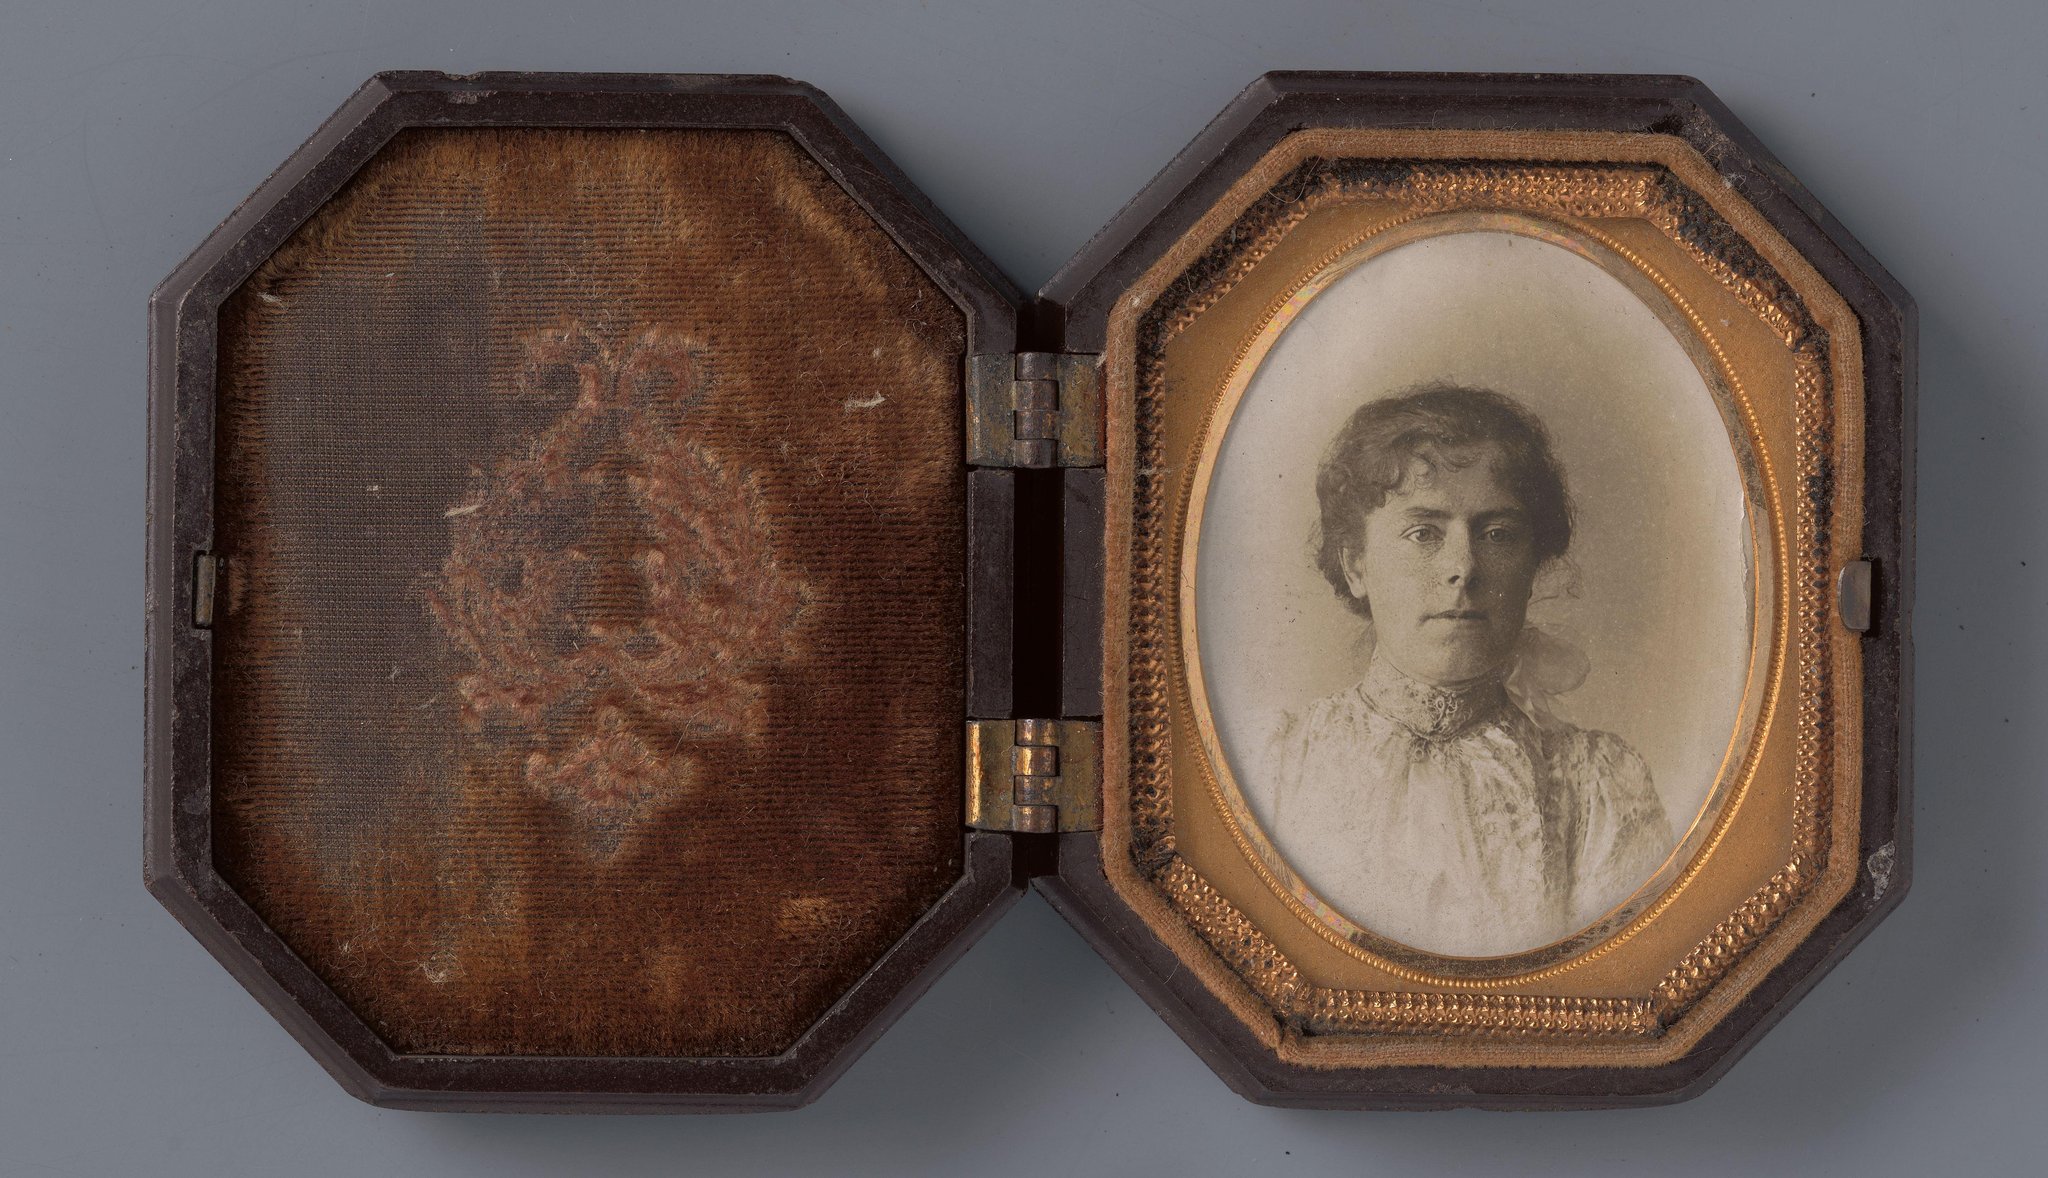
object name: photograph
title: Portret van een onbekende vrouw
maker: Anonymous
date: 1861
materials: glass, metal, photographic support, plastic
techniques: albumen print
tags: adult woman, historical persons